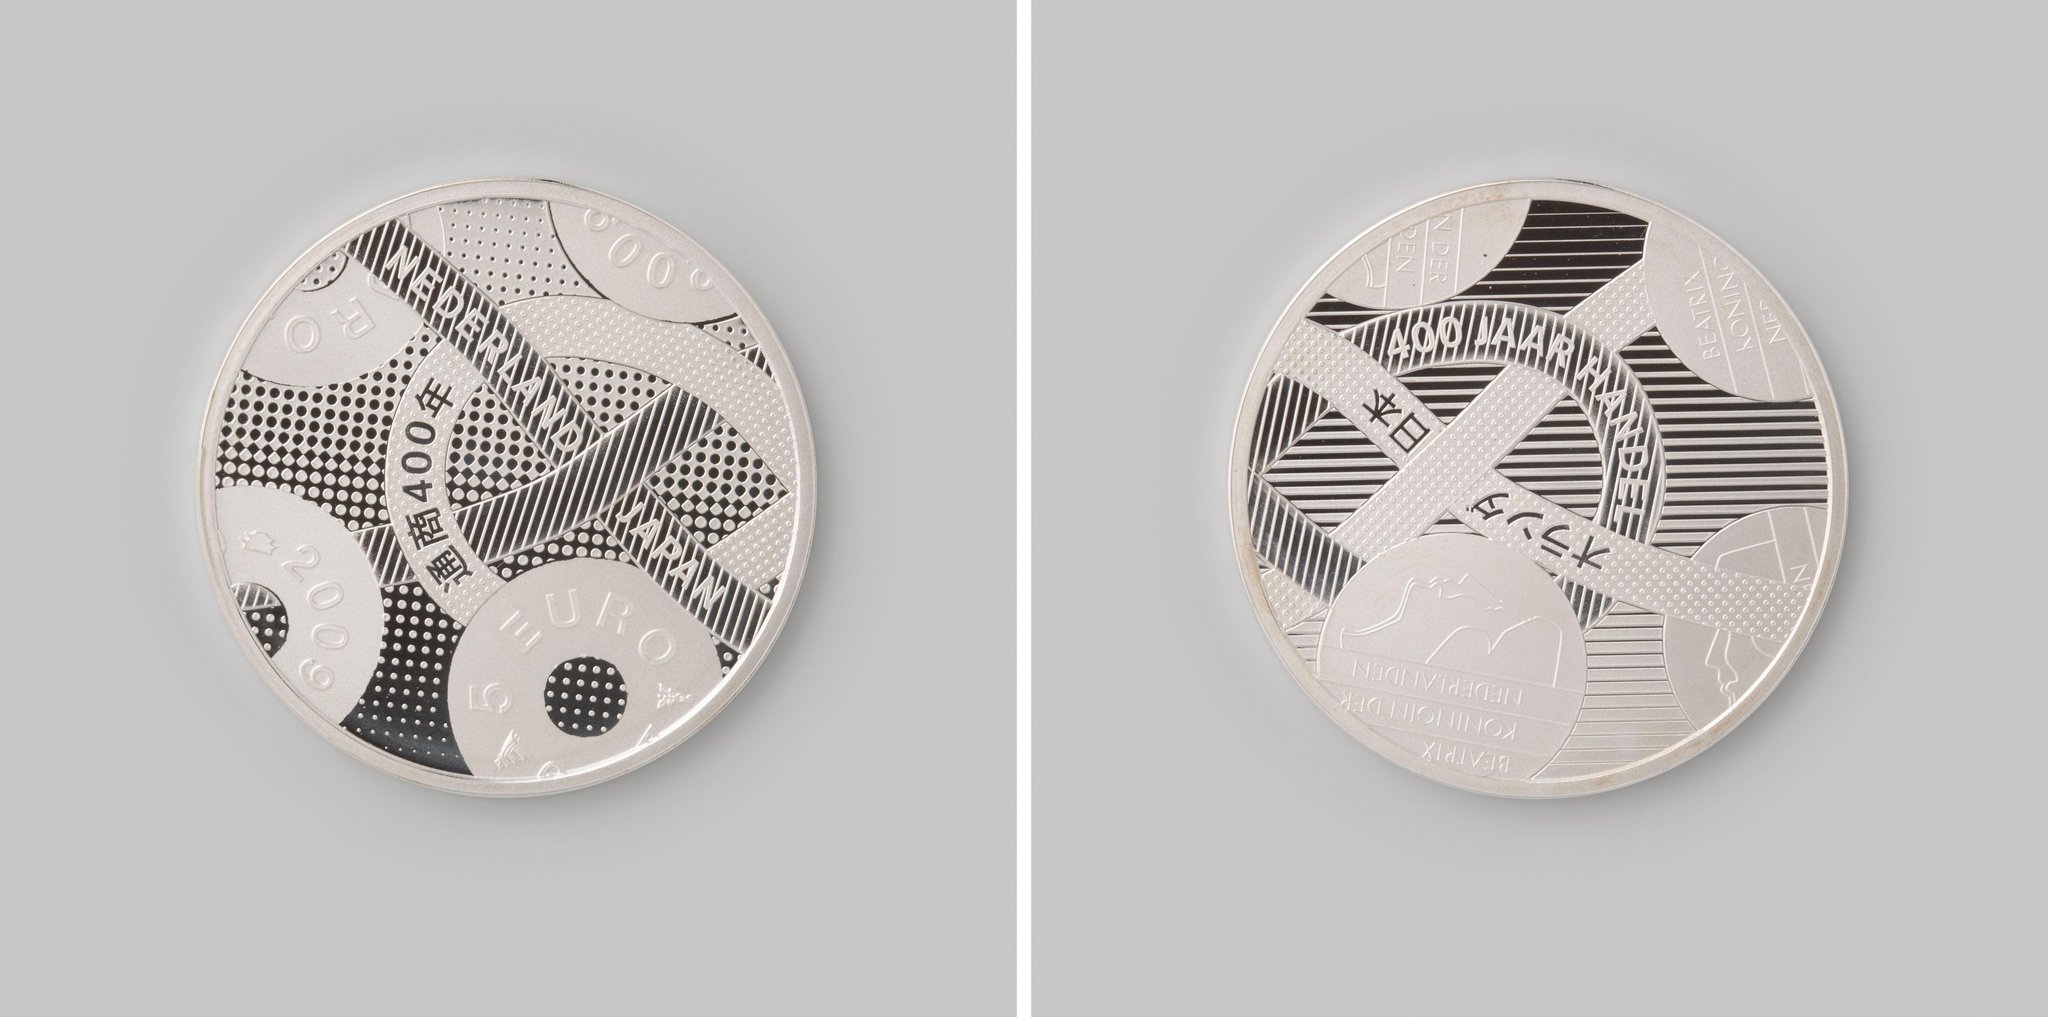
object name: vijf euro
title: Eerste slag : 400 jaar handelsbetrekkingen Nederland-Japan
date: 2009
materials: plastic, silver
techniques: striking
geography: the hague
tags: netherlands, japan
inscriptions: inscription: ‘Nederland Japan 400’, inscription: ‘400 jaar handel’, edge inscription: ‘God zij met ons’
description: Zilveren munt van vijf euro, geslagen ter gelegenheid van 400 jaar handelsbetrekkingen tussen Nederland en Japan. Voor- en keerzijde: linten met tekst en aflopende muntstukken op achtergrond van rasterwerk van strepen en stippen. Op de beide zijden lopen de linten in elkaar over en vormen een platte knoop. Bijbehorend houten doosje met inleg.